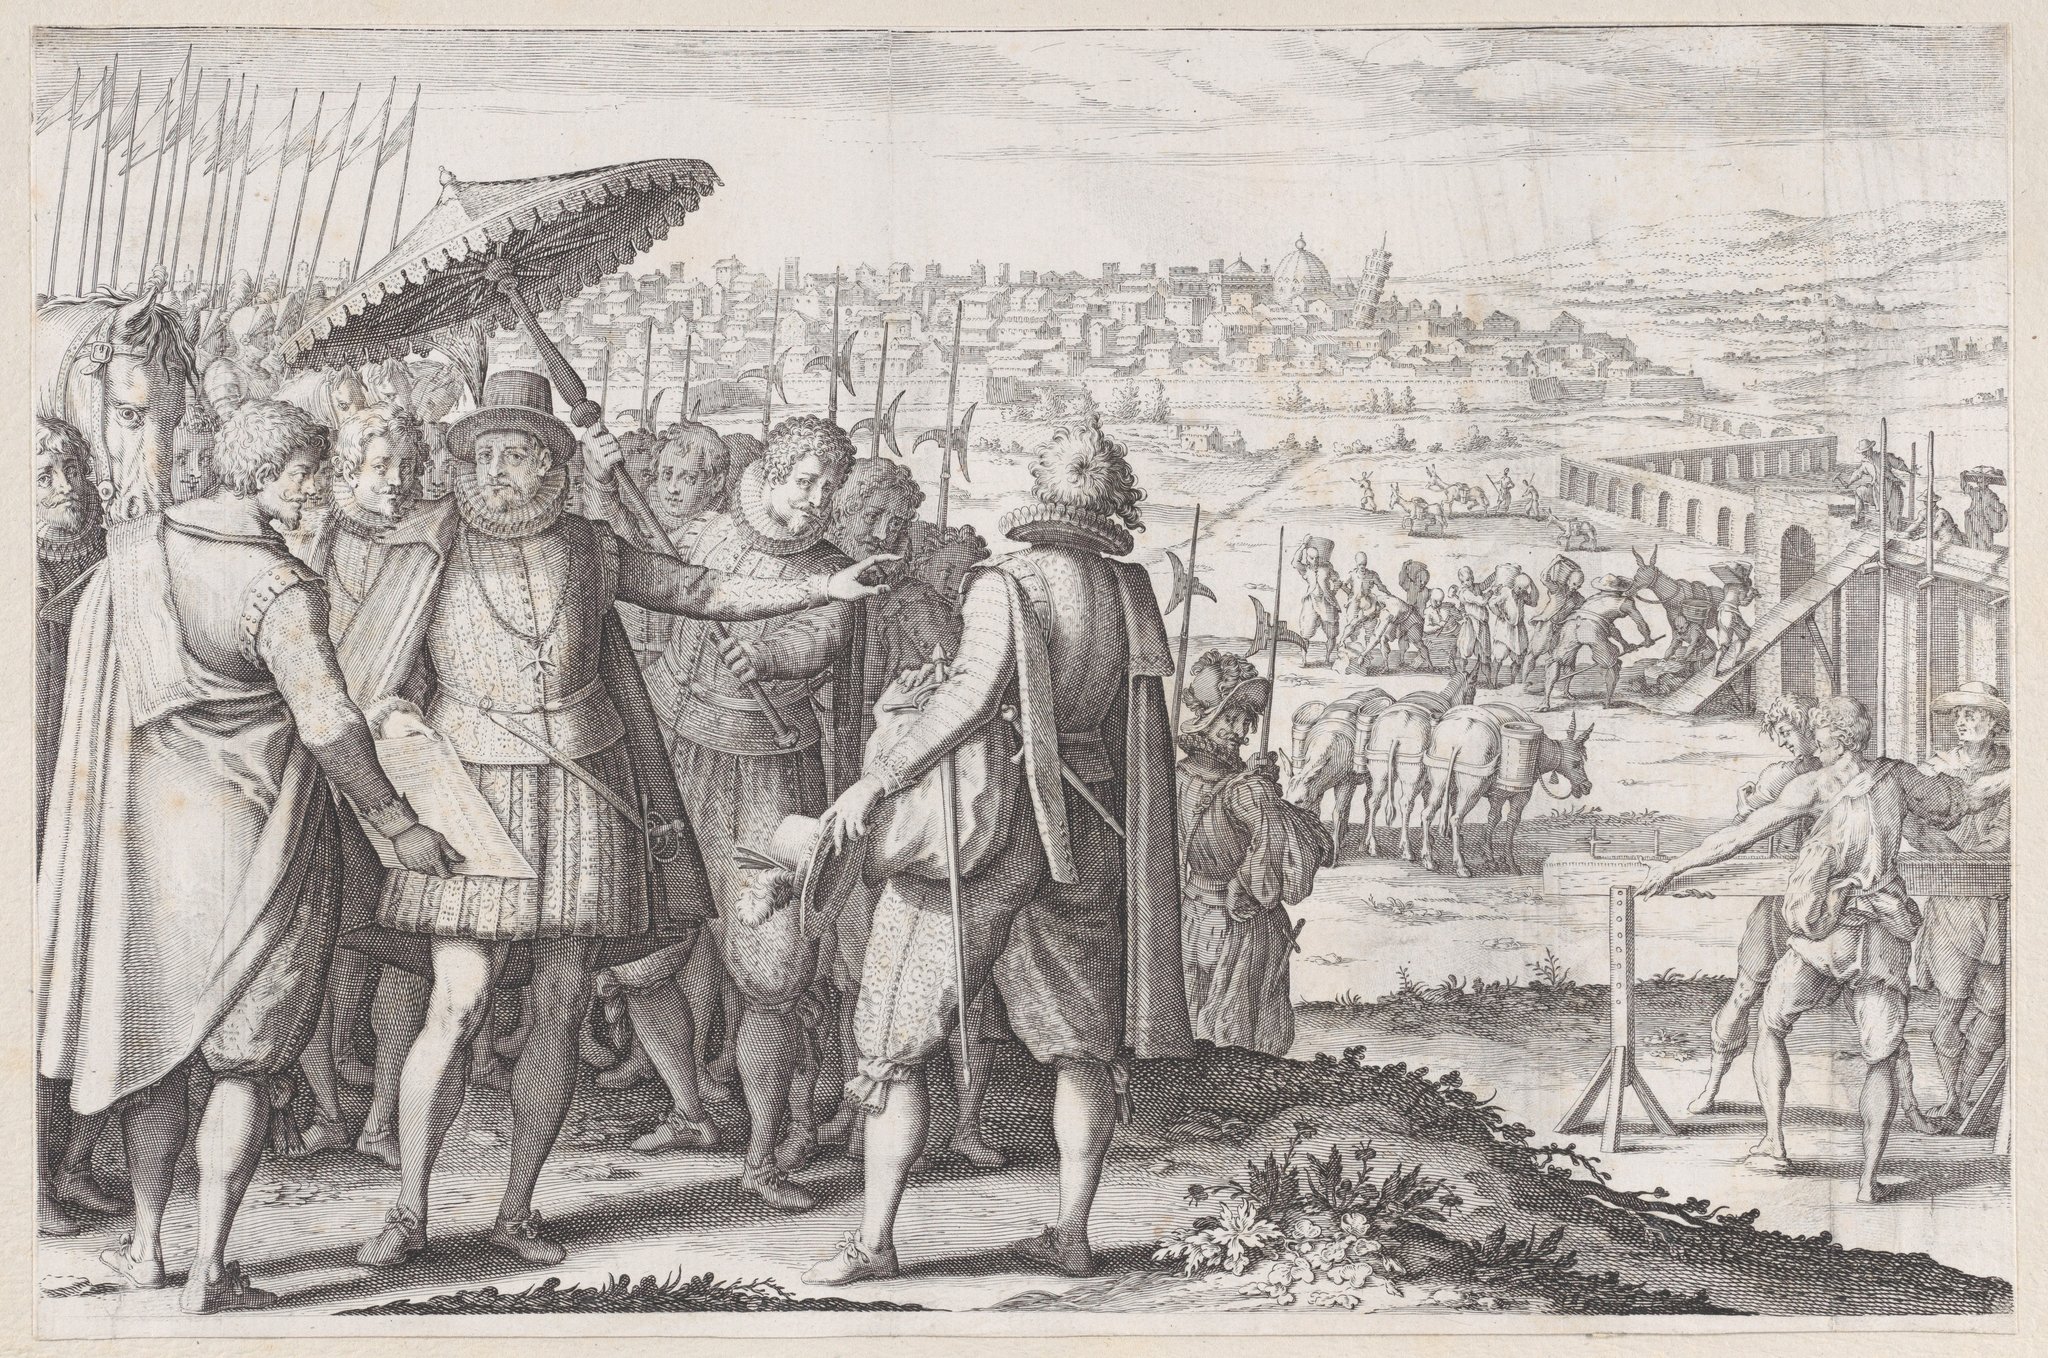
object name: print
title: Restauration de L'Aqueduc de Pise (Restoring the Aqueduct in Pisa), from "La Vie de Ferdinand Ier de Médicis série appelée aussi Les Batailles des Médicis" (The Life of Ferdinand I de'Medici also called The Medici Battles)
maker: jacques callot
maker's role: artist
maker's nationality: french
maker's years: 1592-1635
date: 1614-1620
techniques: engraving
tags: men,aqueducts